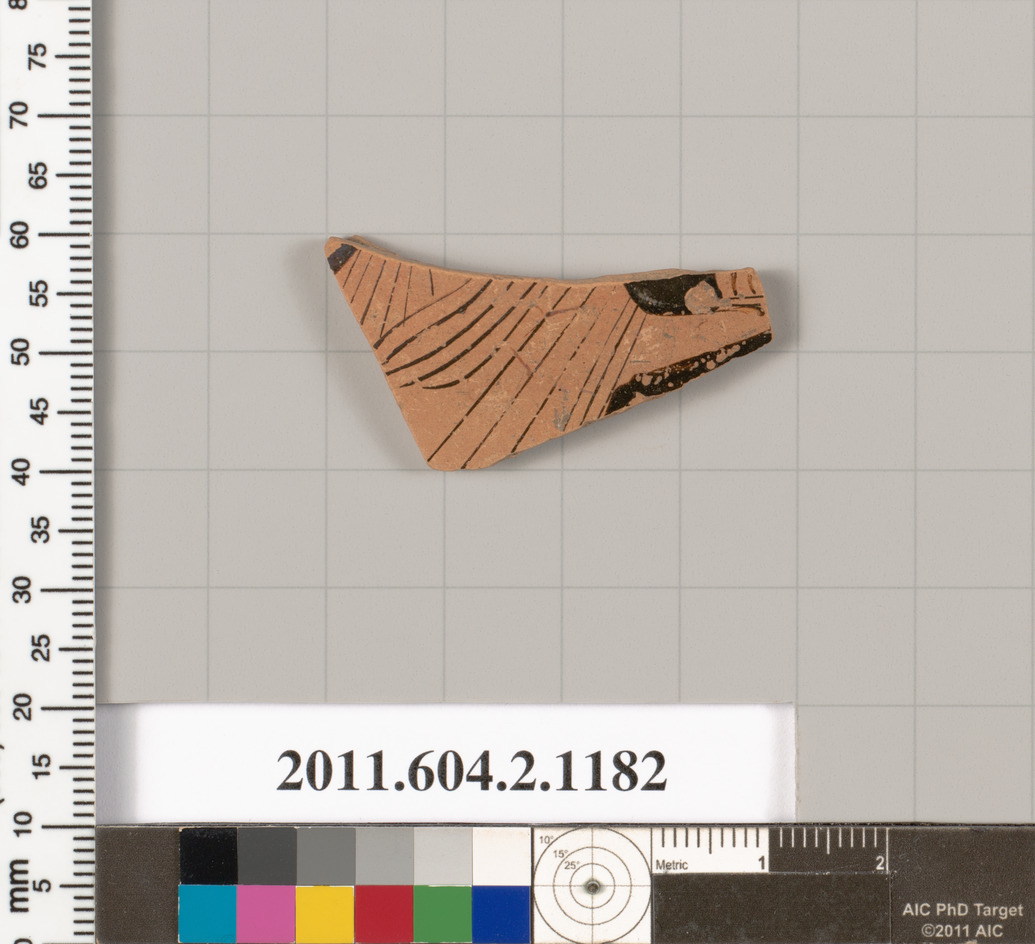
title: Terracotta fragment of a small, closed shape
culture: greek, attic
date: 450-401 BCE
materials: terracotta